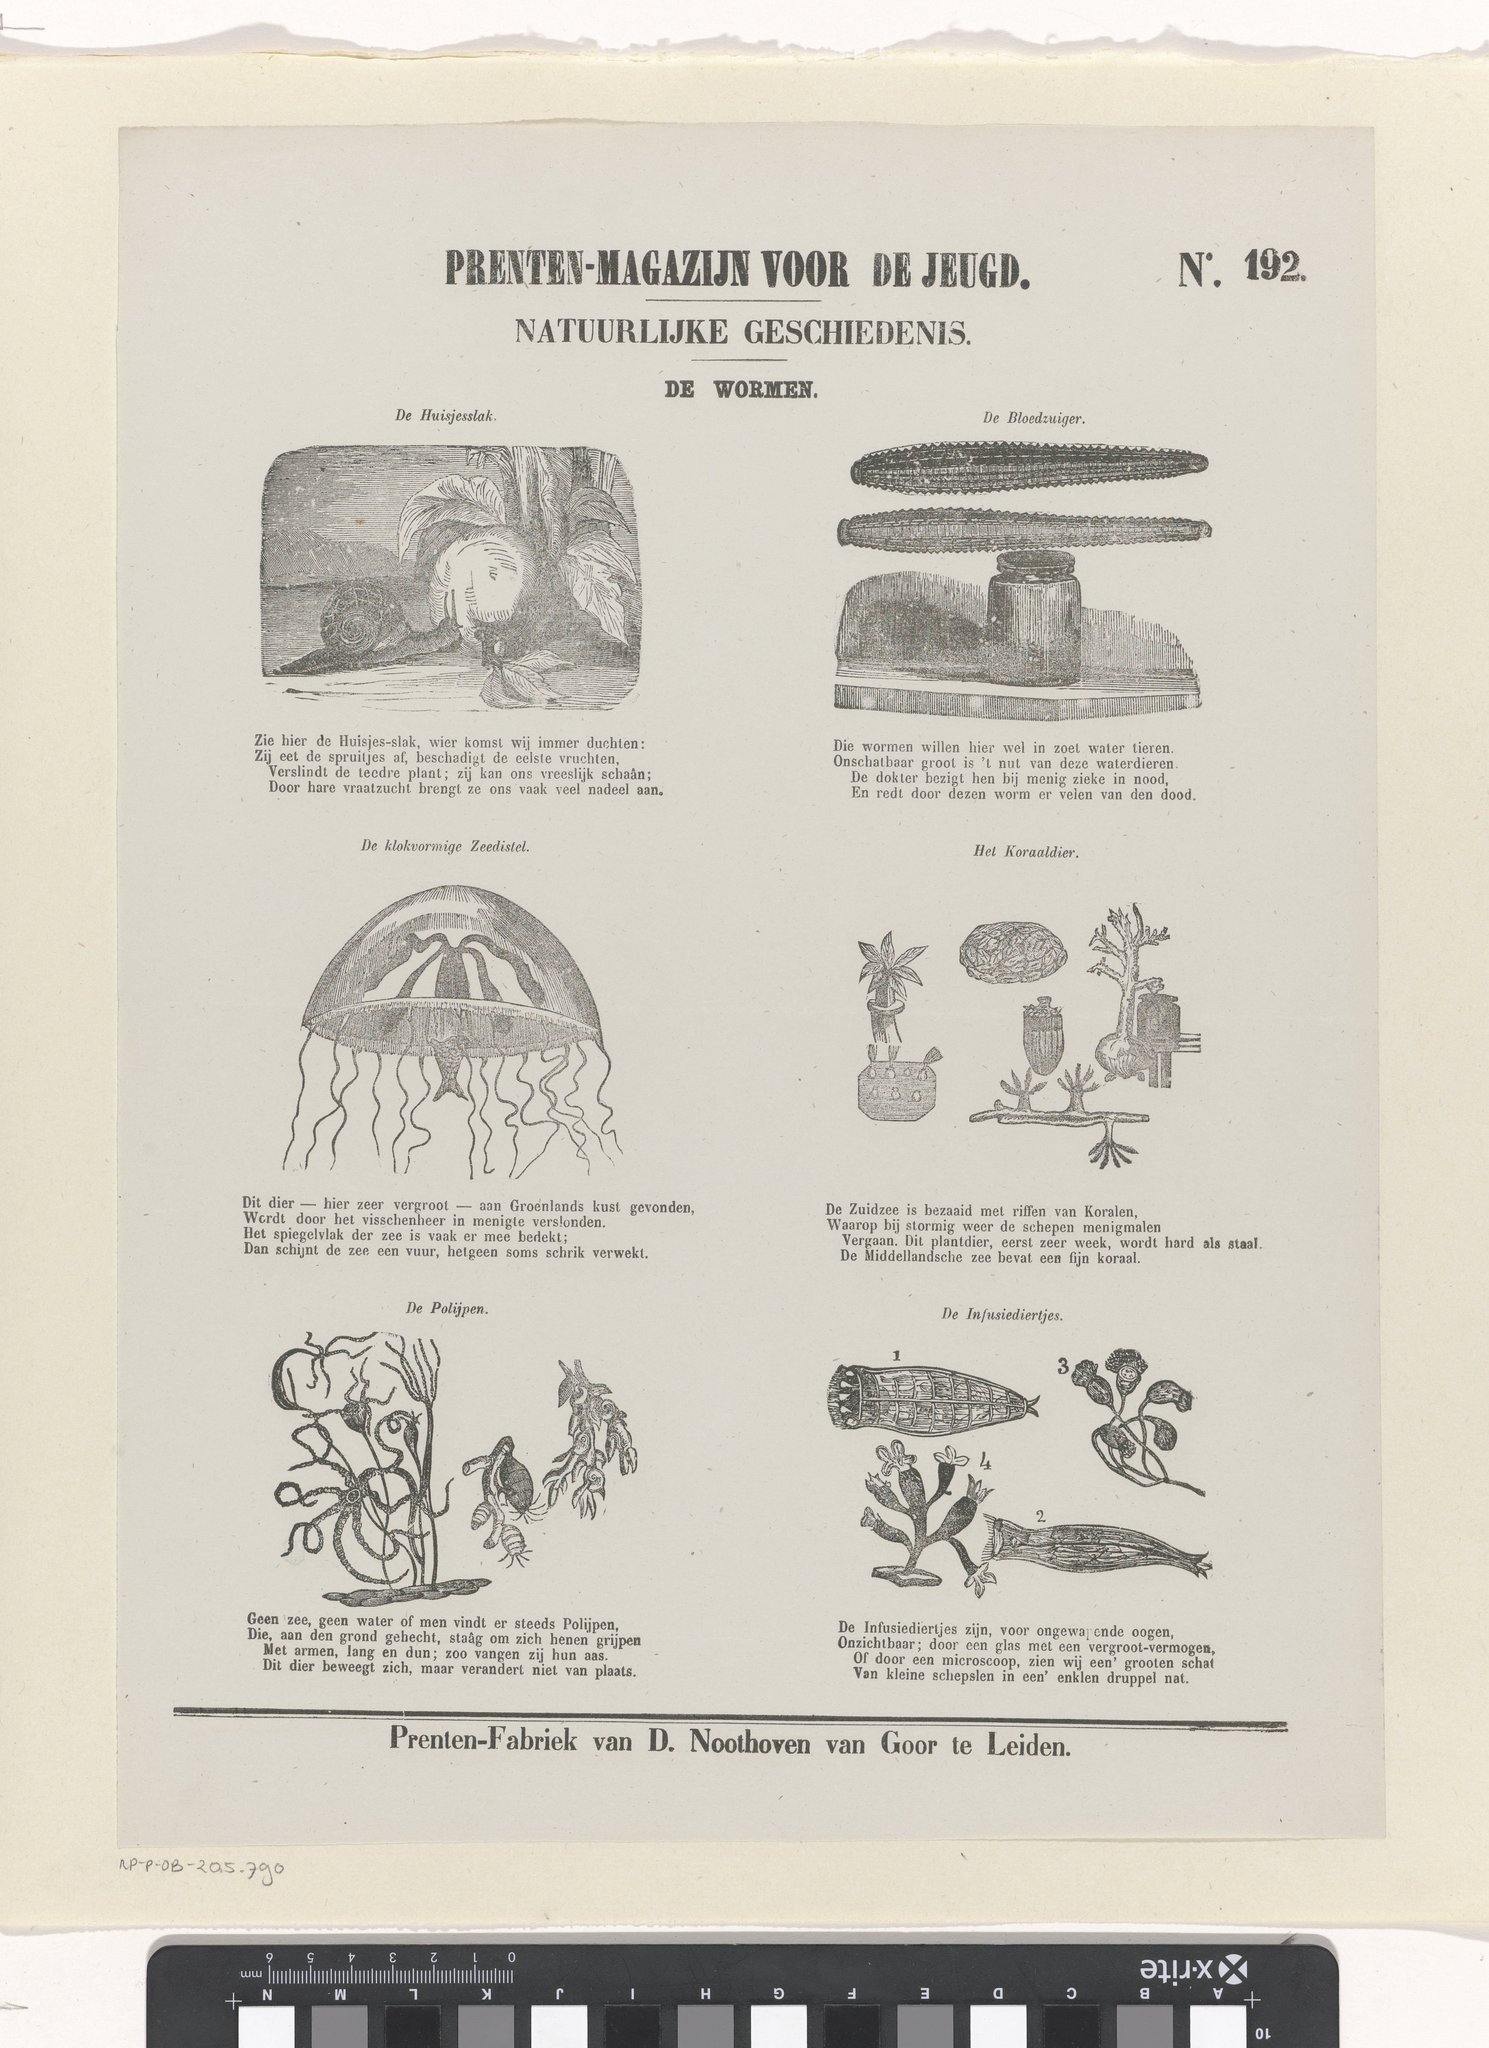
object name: popular print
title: Natuurlijke geschiedenis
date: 1850-1881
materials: paper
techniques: letterpress printing, engraving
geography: leiden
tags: worms, coelenterata: coral, coelenterata: jelly-fish, molluscs: snail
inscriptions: collector's mark: Lugt 2760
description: Blad met 6 voorstellingen van dieren, zoals slakken, bloedzuigers en een kwal. Boven elke afbeelding een titel, onder elke afbeelding een vierregelig vers. Genummerd rechtsboven: No. 192.